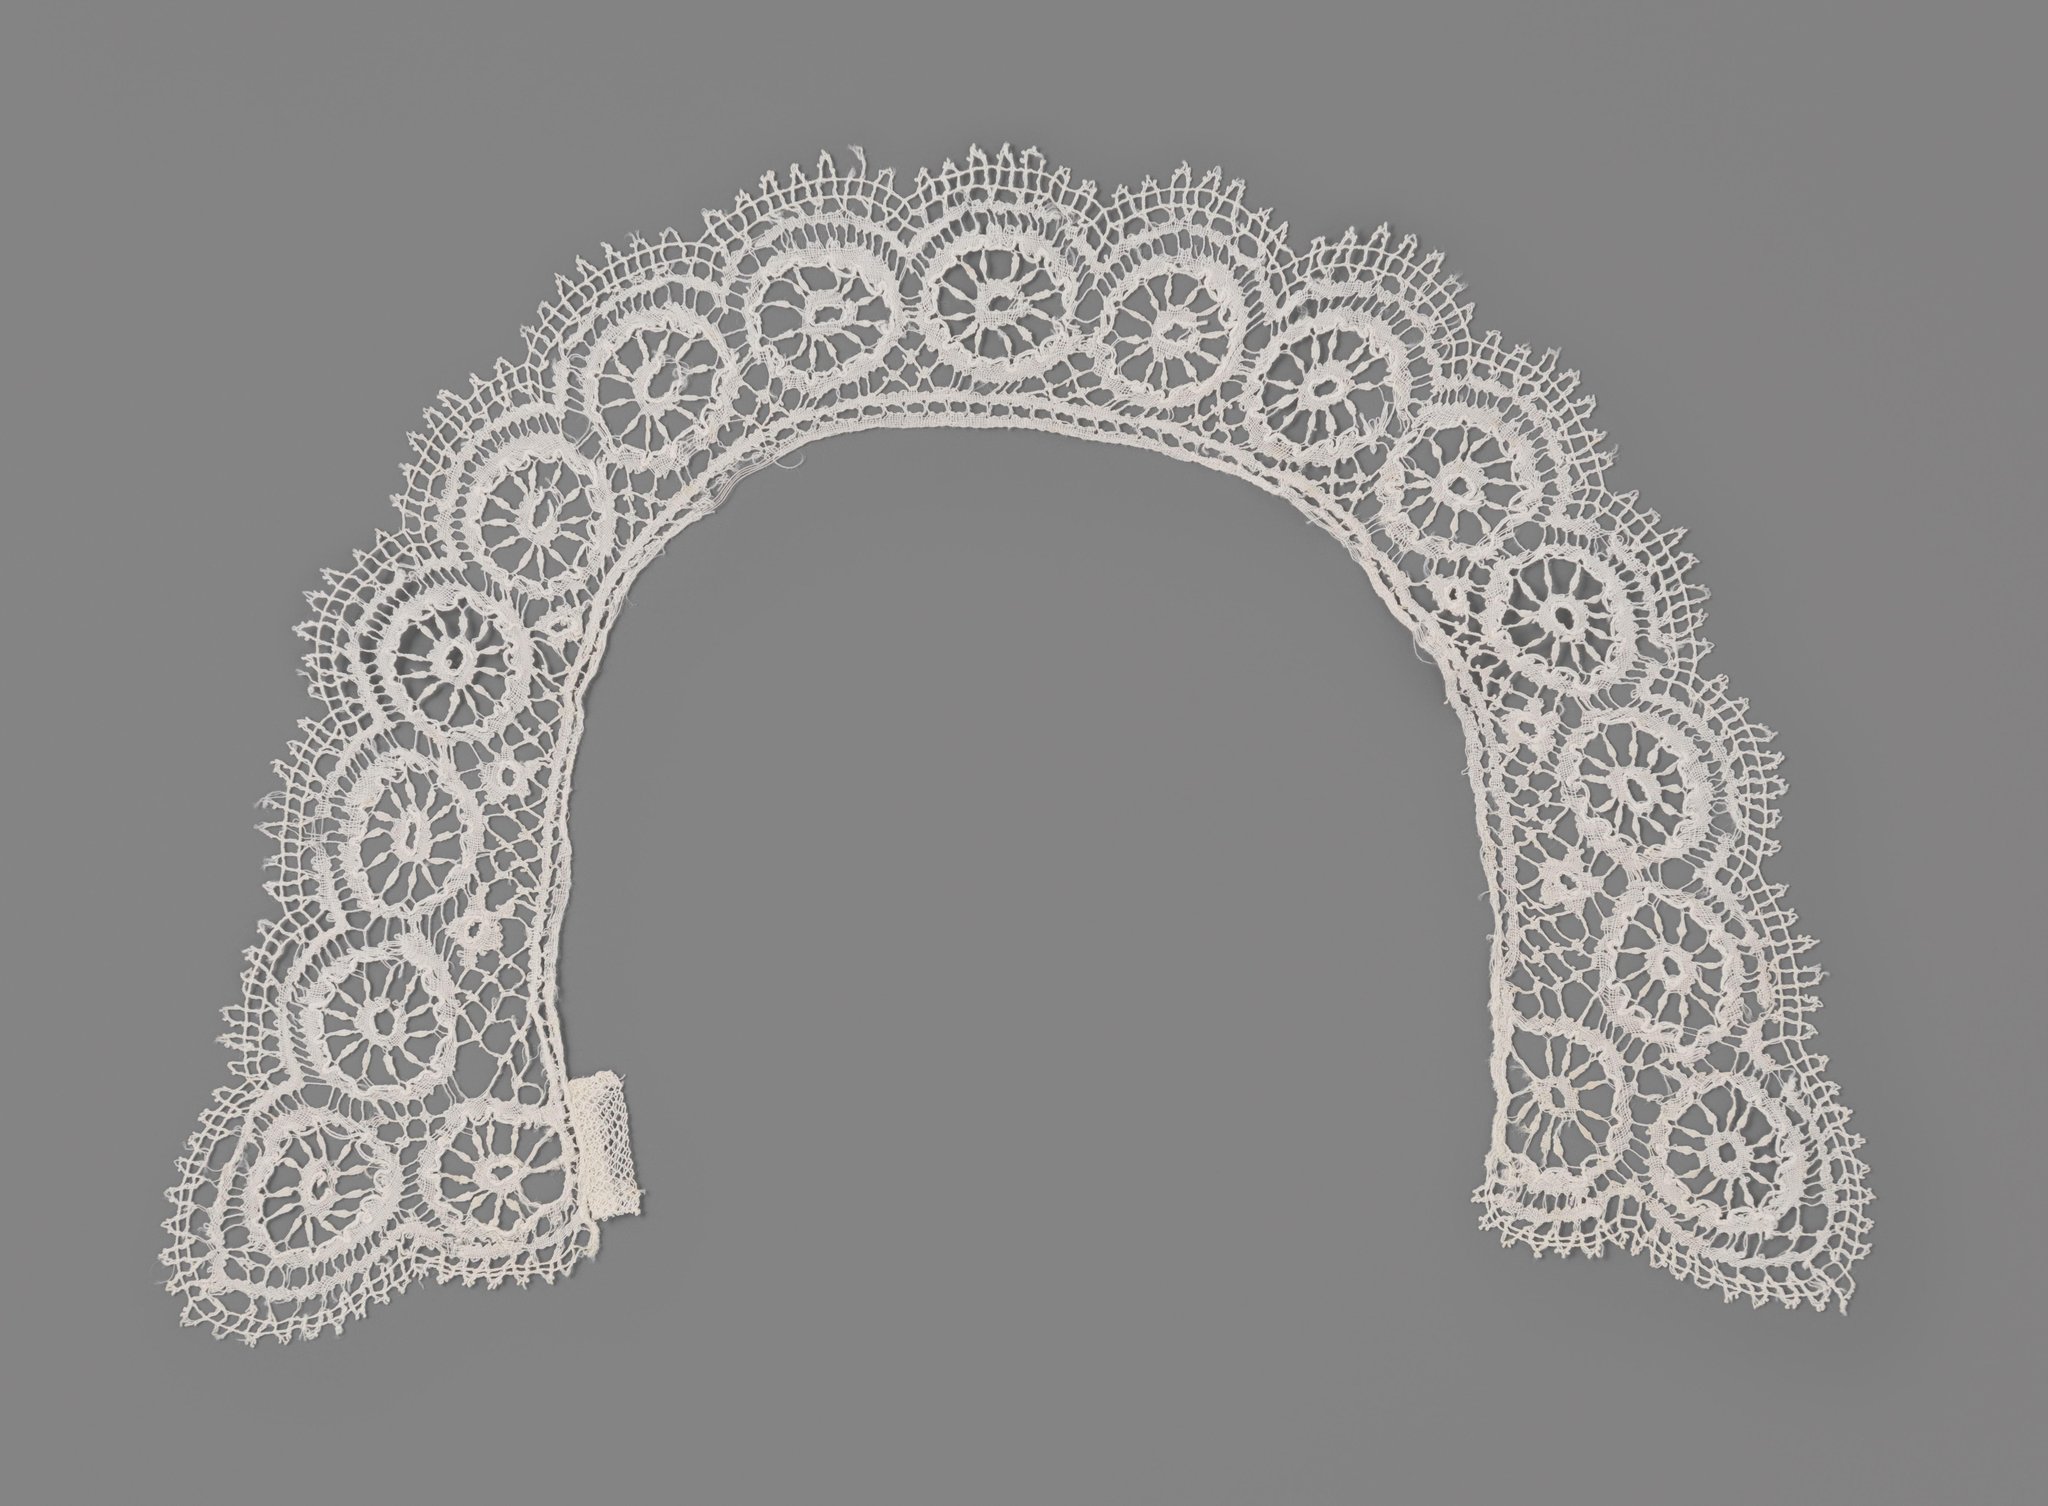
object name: collar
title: Kraag van Clunykant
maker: Anonymous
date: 1900-1925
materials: lace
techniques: lace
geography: western europe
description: Kraag van Clunykant. Liggende ronde kraag met verlengde punten van kloskant, versierd met een rij wieltjes en een schulprand.